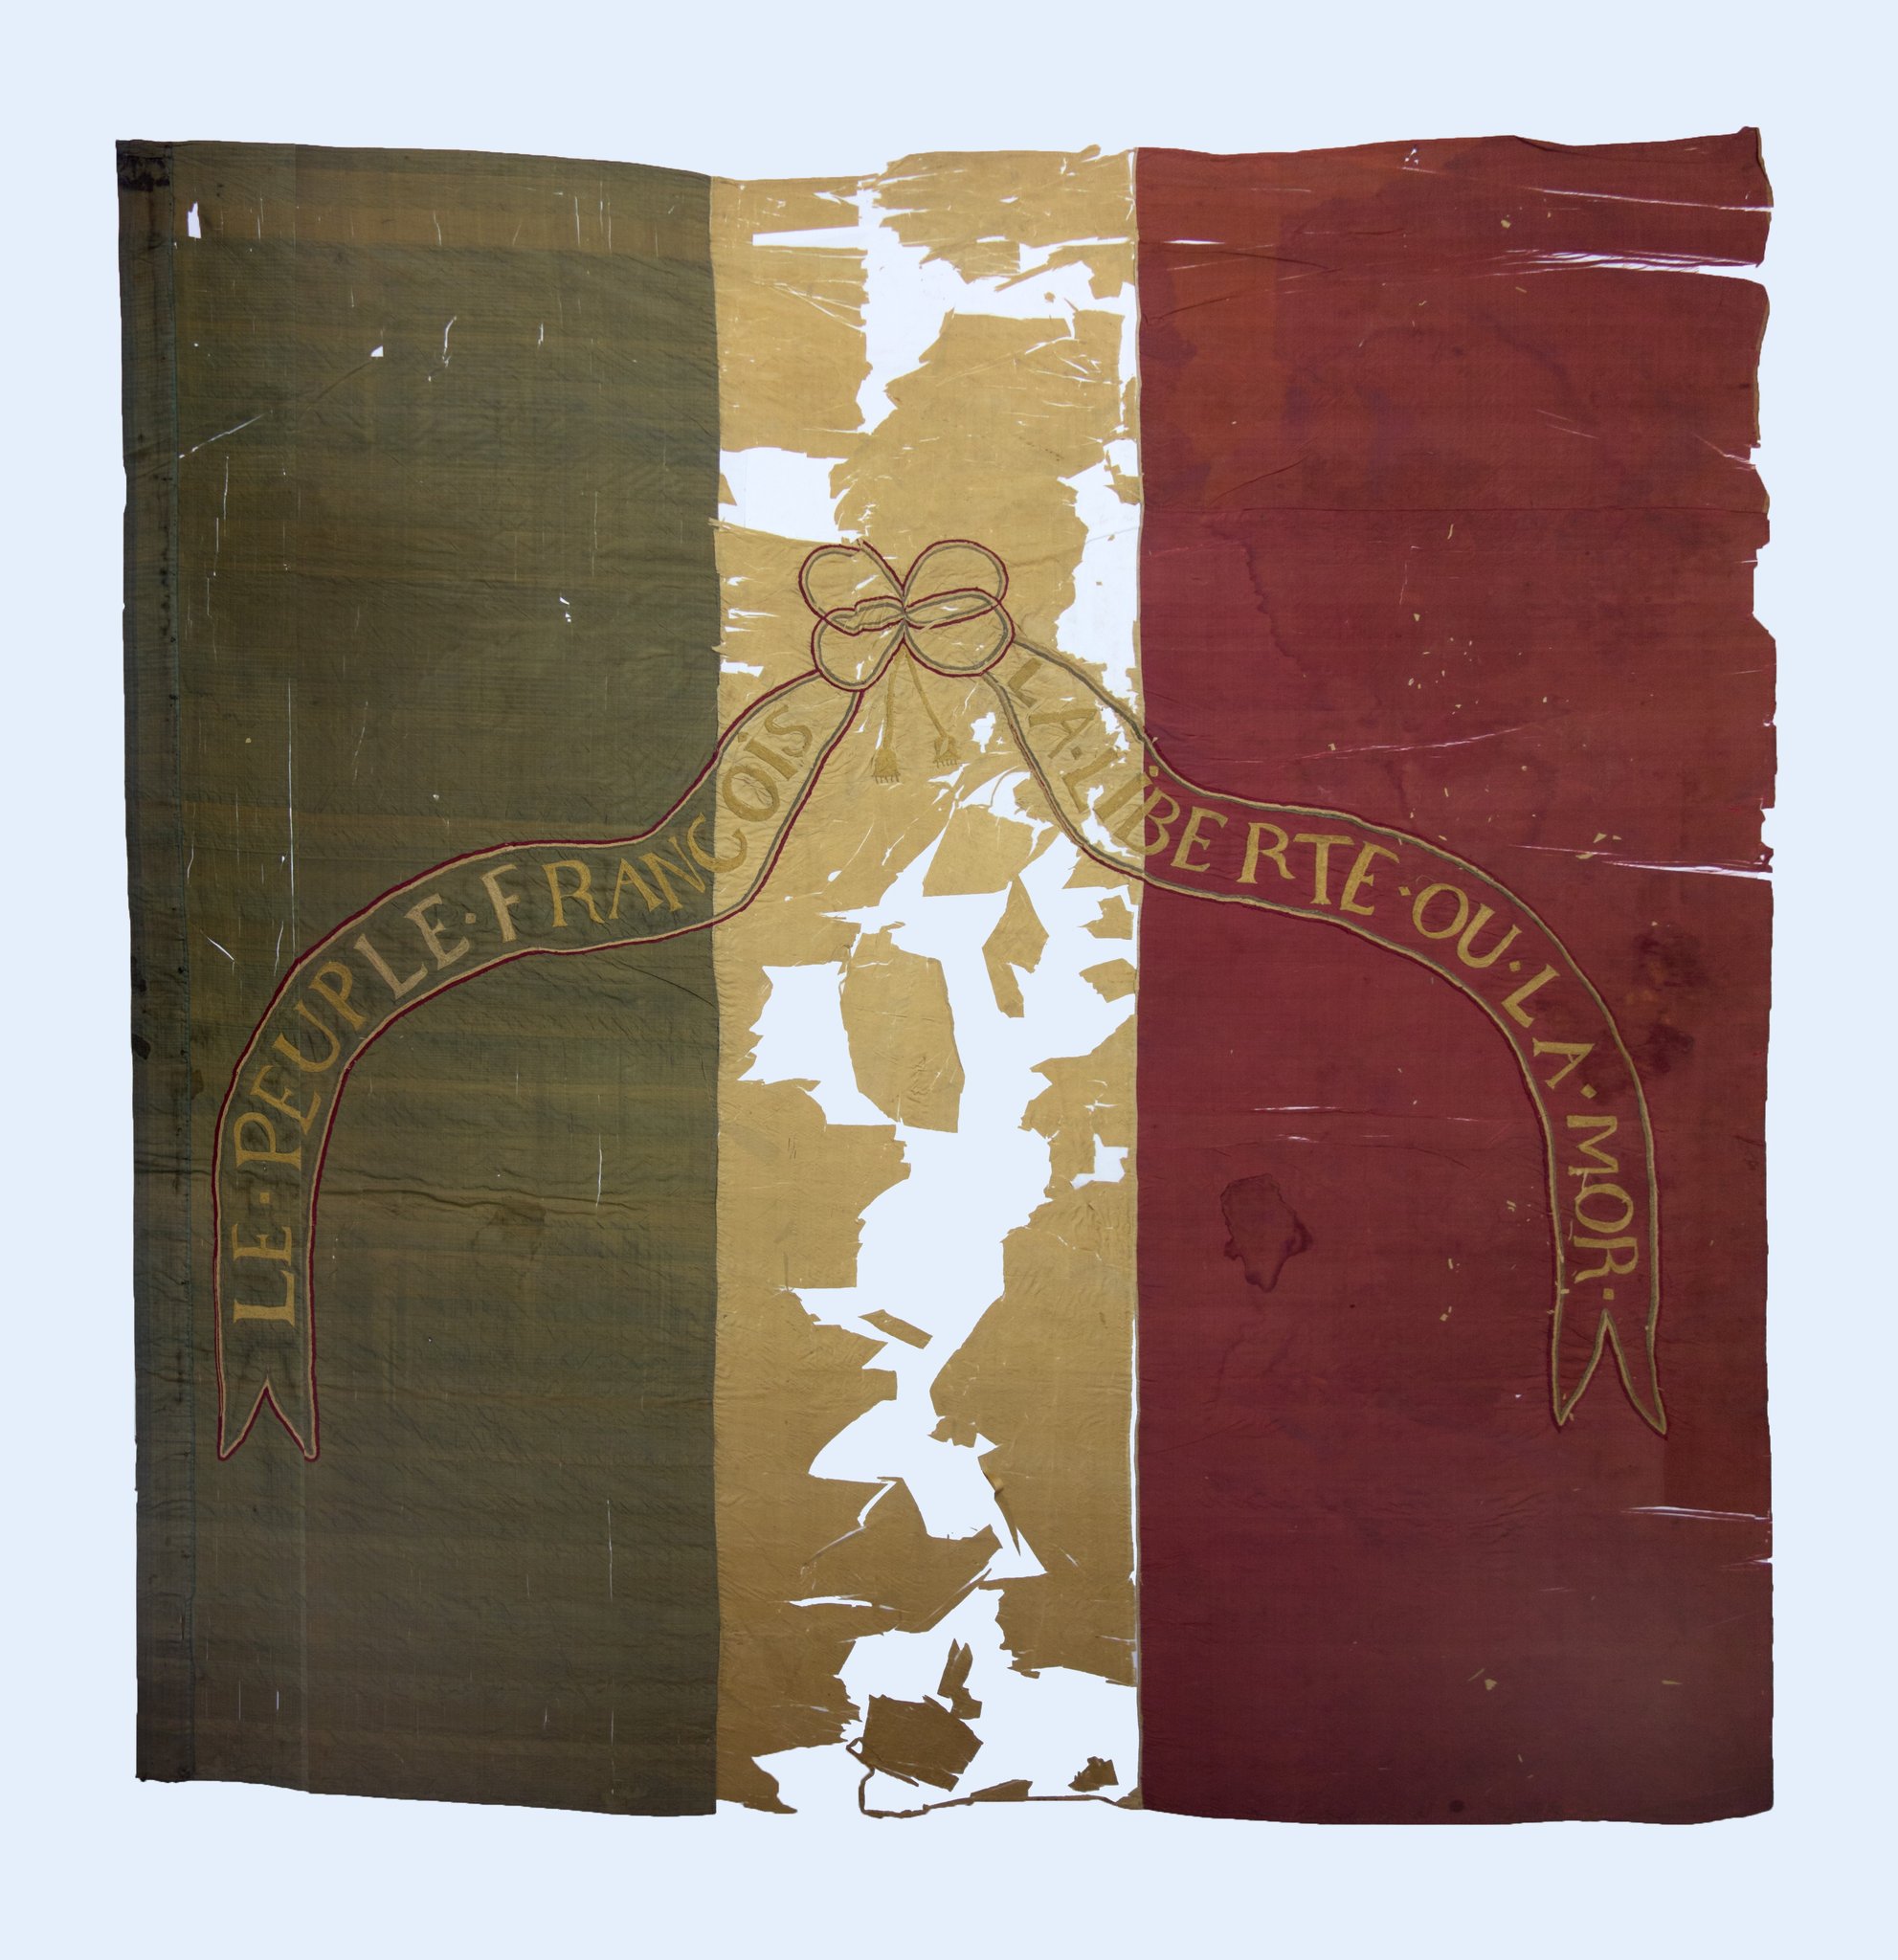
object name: banner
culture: french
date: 1793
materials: silk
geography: france